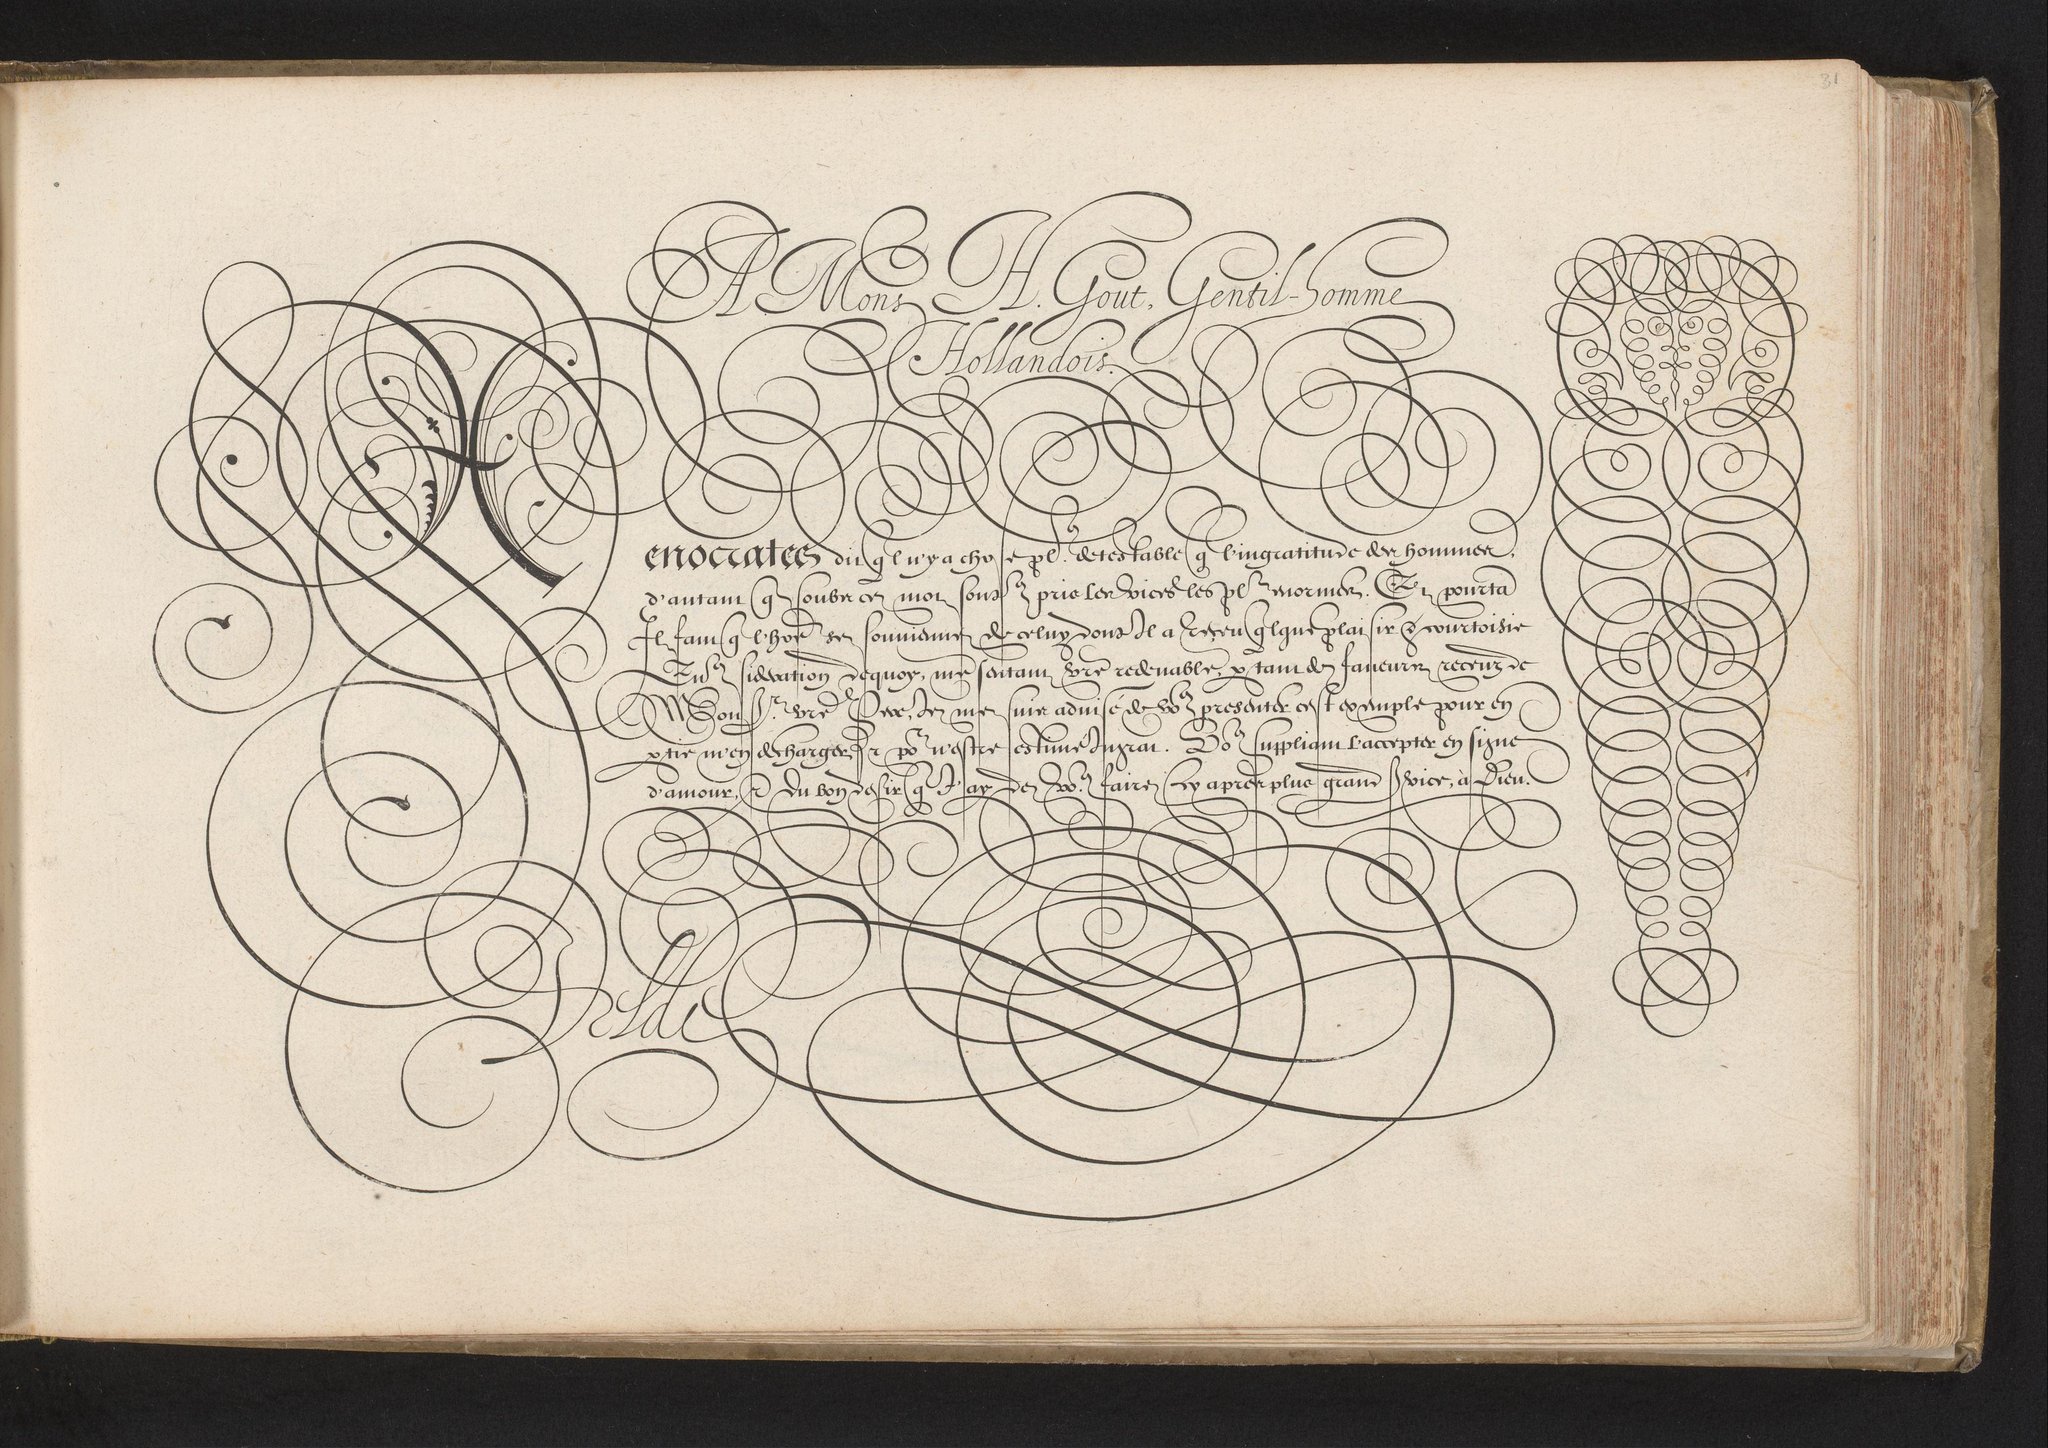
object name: album leaf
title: Schrijfvoorbeeld: A Mons H. Gout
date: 1605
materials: paper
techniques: engraving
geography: rotterdam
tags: calligraphy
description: Schrijfvoorbeeld met de aanhef: A mons H. Gout gentil-homme Hollandois. Daaronder in een andere letter een initiaal X en zeven regels tekst in het Frans: Xenocrates dit q(ui)l n'y a ... De tekst is omlijst door krulwerk. De prent maakt deel uit van een album.